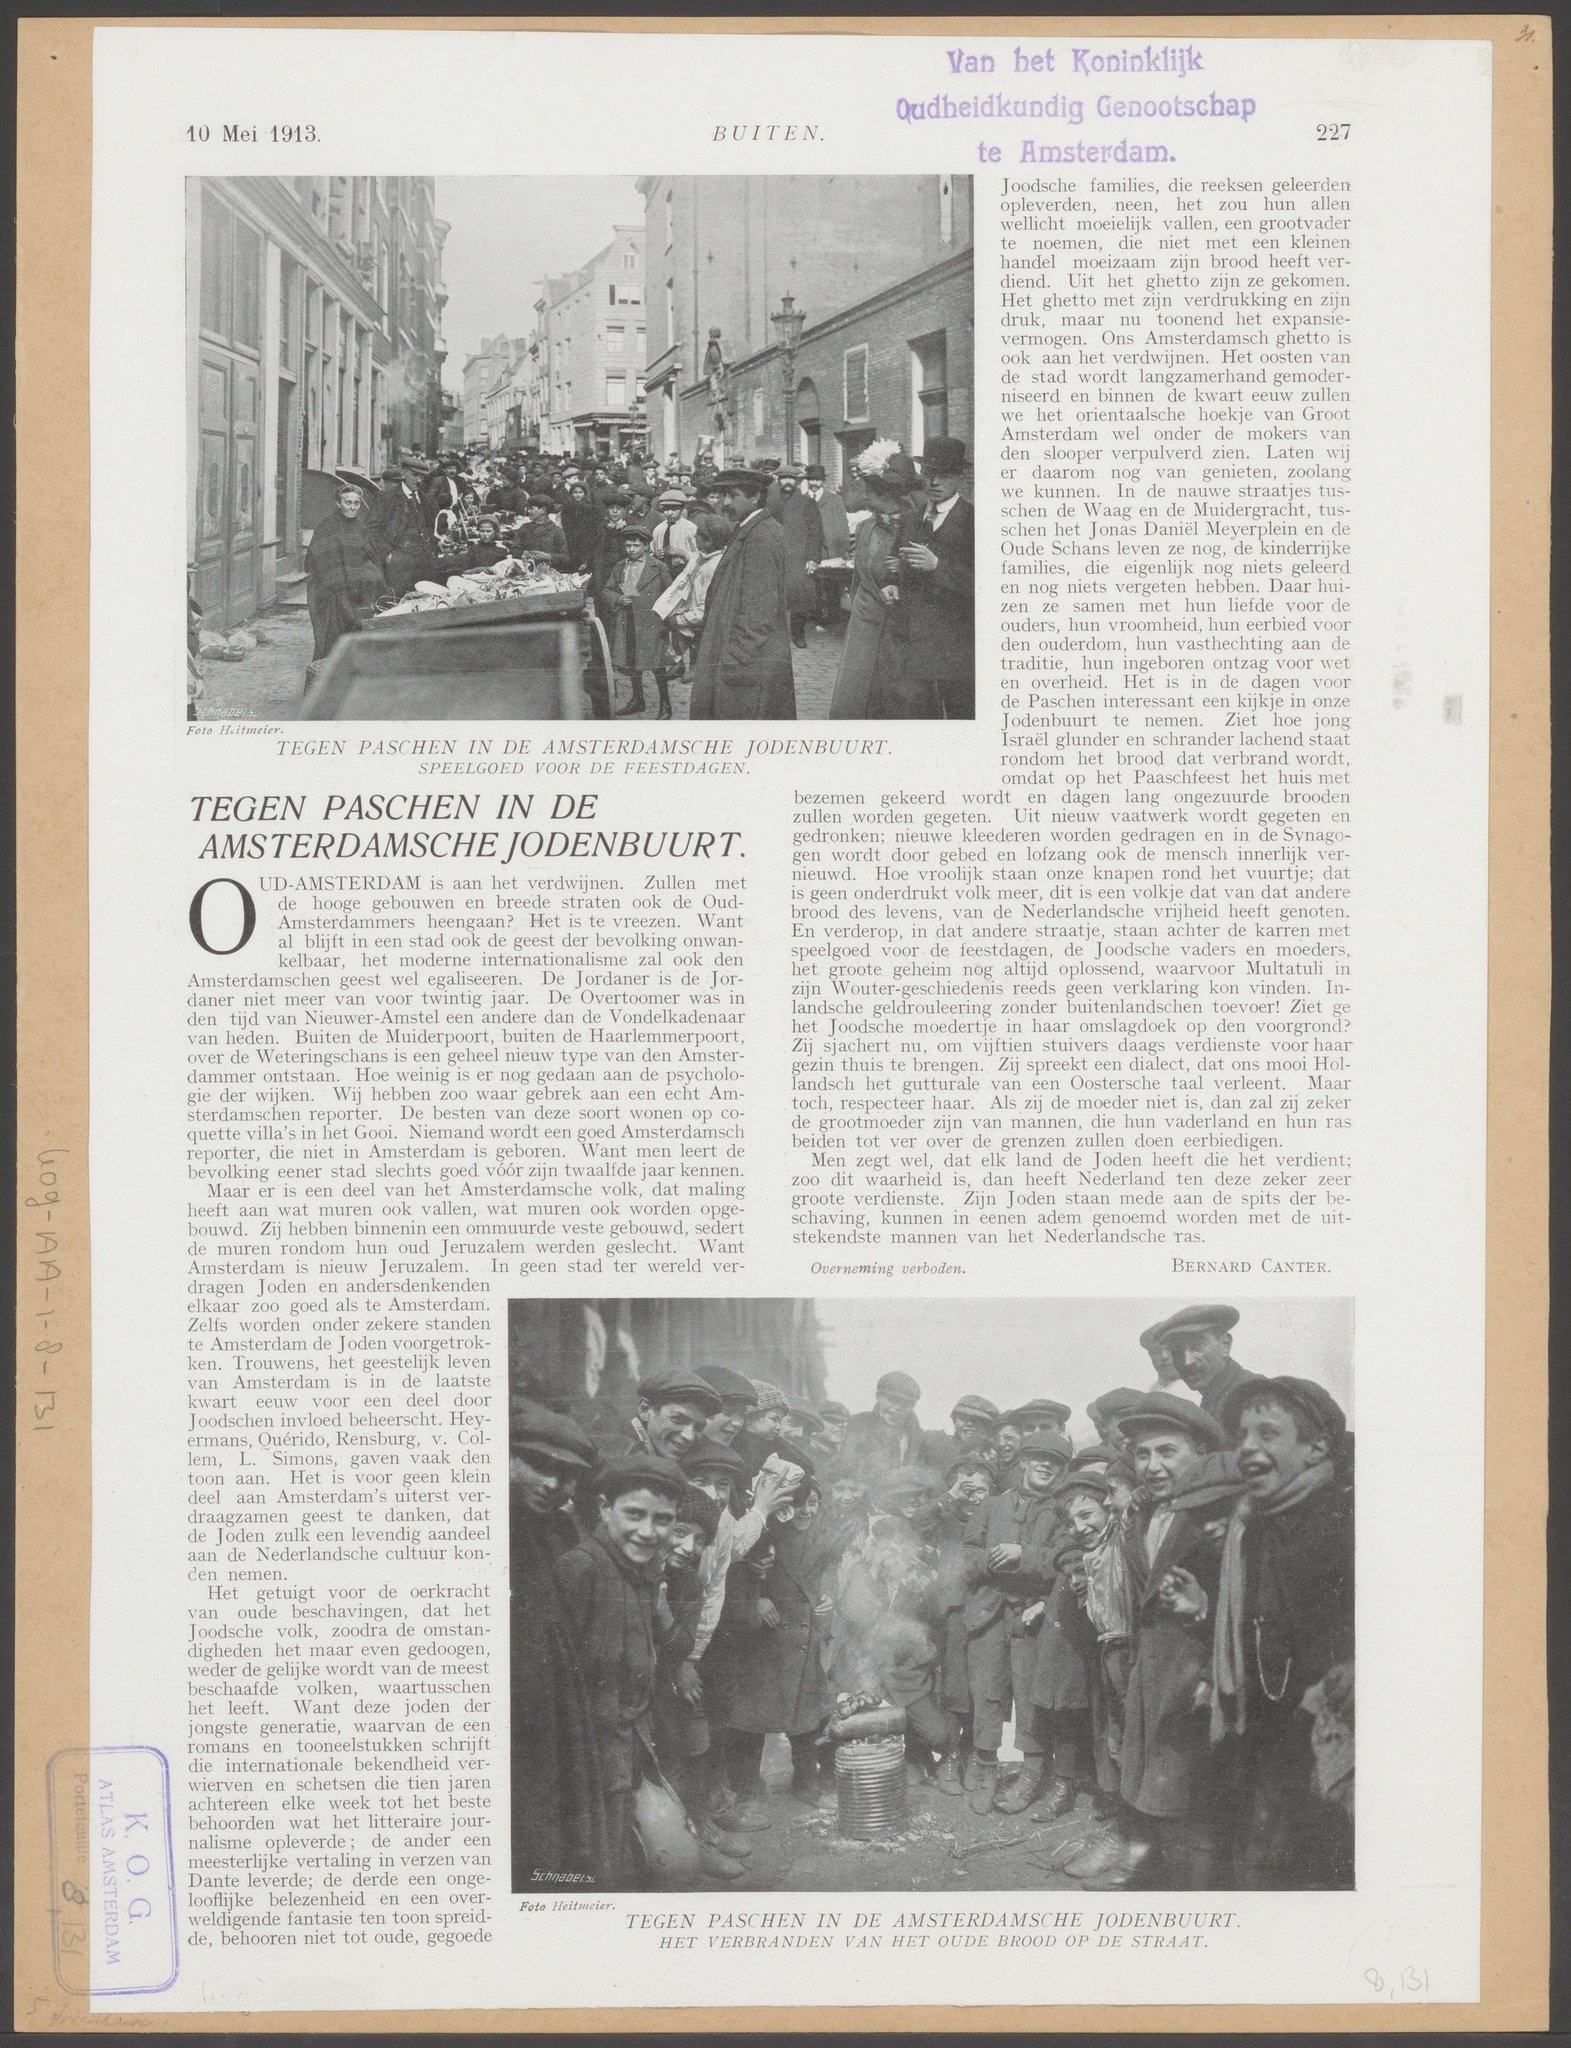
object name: photomechanical print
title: Gezichten op enkele straten in de omgeving van de Jodenbreestraat rond de Paasviering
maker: Anonymous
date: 1913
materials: paper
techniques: letterpress printing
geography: amsterdam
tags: city-view in general; 'veduta', street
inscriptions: stamp: ‘Van het Koninklijk / Oudheidkundig Genootschap / te Amsterdam.’, collector's mark: ‘8,131’ Lugt 1641b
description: Onderwerpsrubriek binnen de Atlas Amsterdam: Jacobszstraat (Pieter), Jodenbreestraat, Jodenhoek, Jonge Roelensteeg, Jonker- en Ridderstraat.